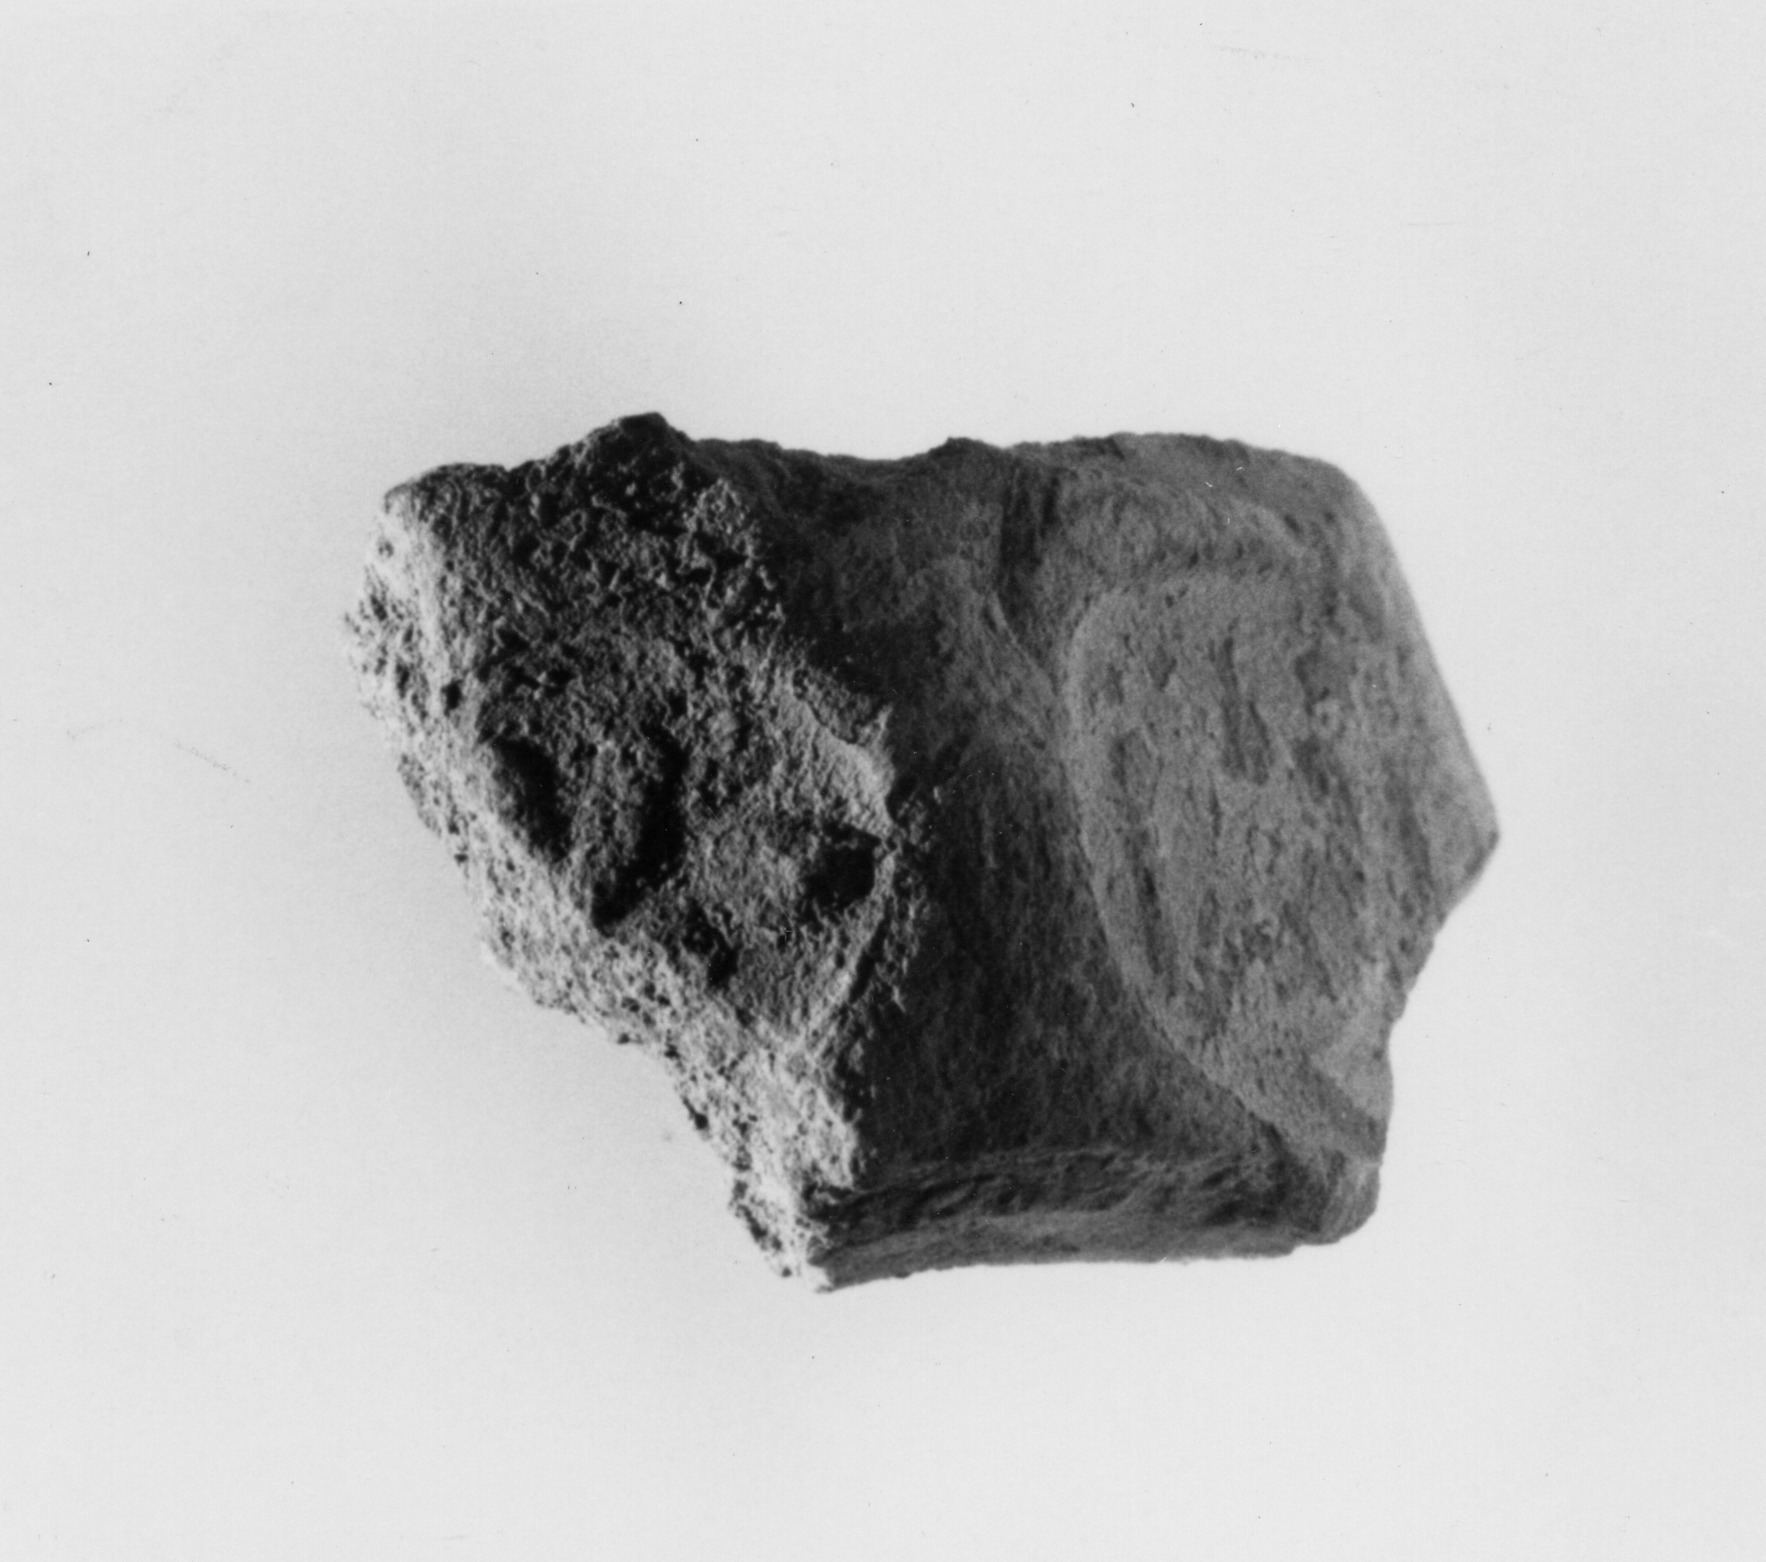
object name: sealing, nebmaatre, amenhotep iii, bee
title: Document Sealing With Multiple Seal Impressions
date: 1390-1352 BCE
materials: mud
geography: egypt